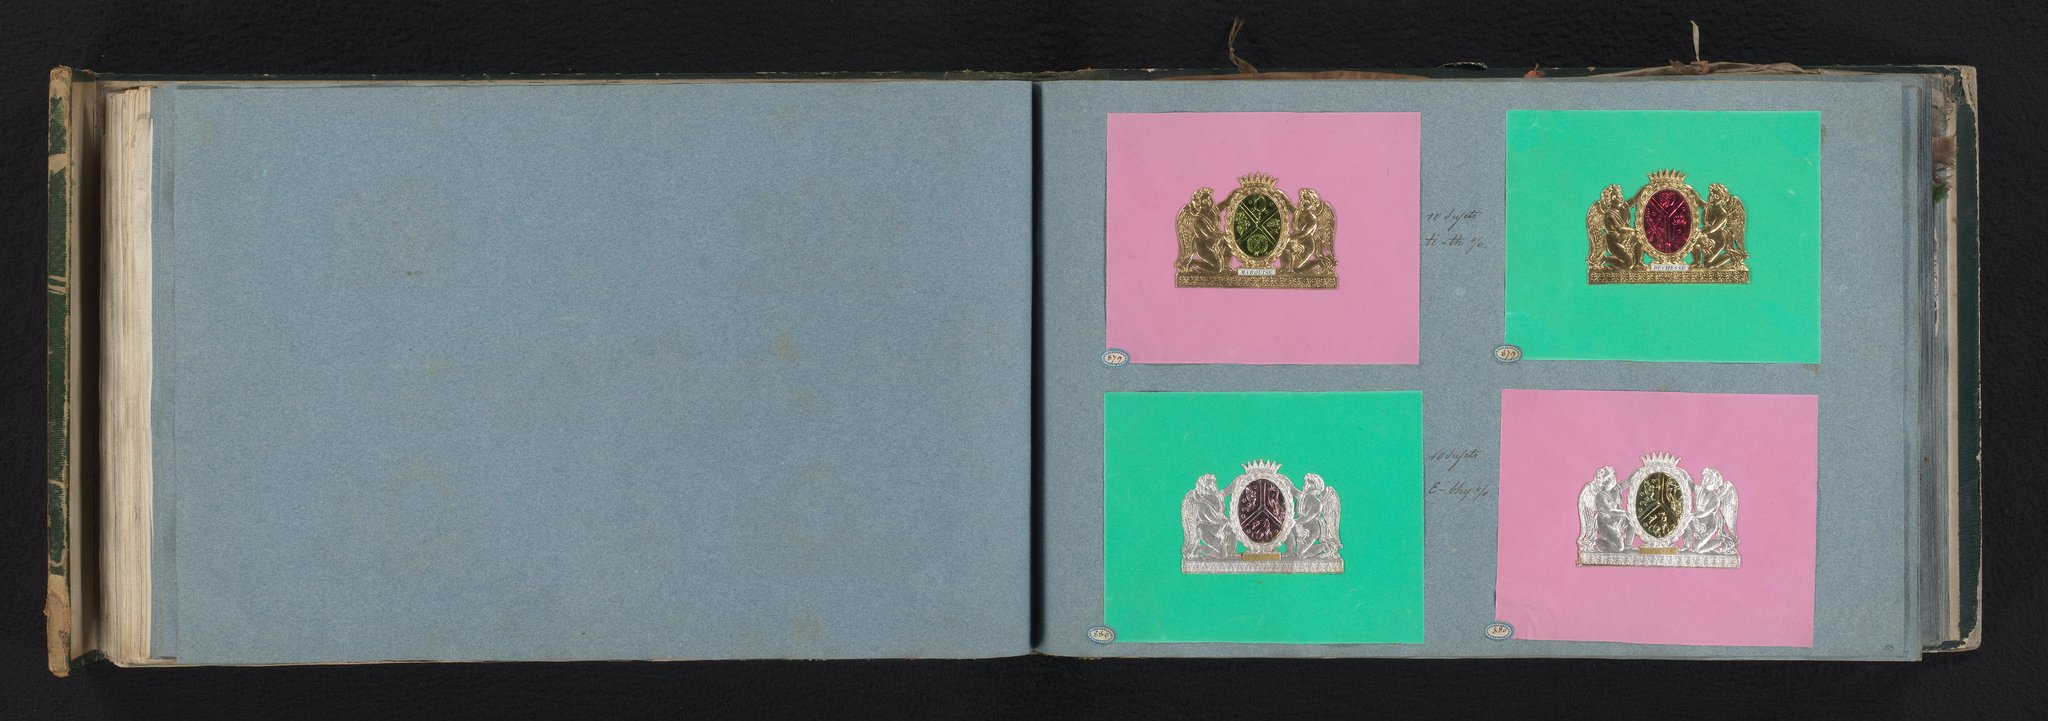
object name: sample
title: Twee bladzijden met stalen van goud- en zilverkleurige vignetten op gekleurd papier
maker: Anonymous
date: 1830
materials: gold leaf, ink, paper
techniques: manufacturing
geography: france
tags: ornaments ~ art, armorial bearing, heraldry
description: Twee bladzijden met rechts 4 opgeplakte stalen van gekleurd papier voorzien van goud- en zilverkleurige vignetten van een fantasiewapen met adellijke titel en twee putti als schildhouders. De linkerbladzijde is leeg. Alle stalen voorzien van etiketten met nummers (879-880) en handgeschreven codes. Onderdeel van het stalenboek geschonken door de dames Van Rijn, vermoedelijk van een Franse papierfabrikant van luxe papieren, of diens vertegenwoordiger in Nederland, ca. 1830.